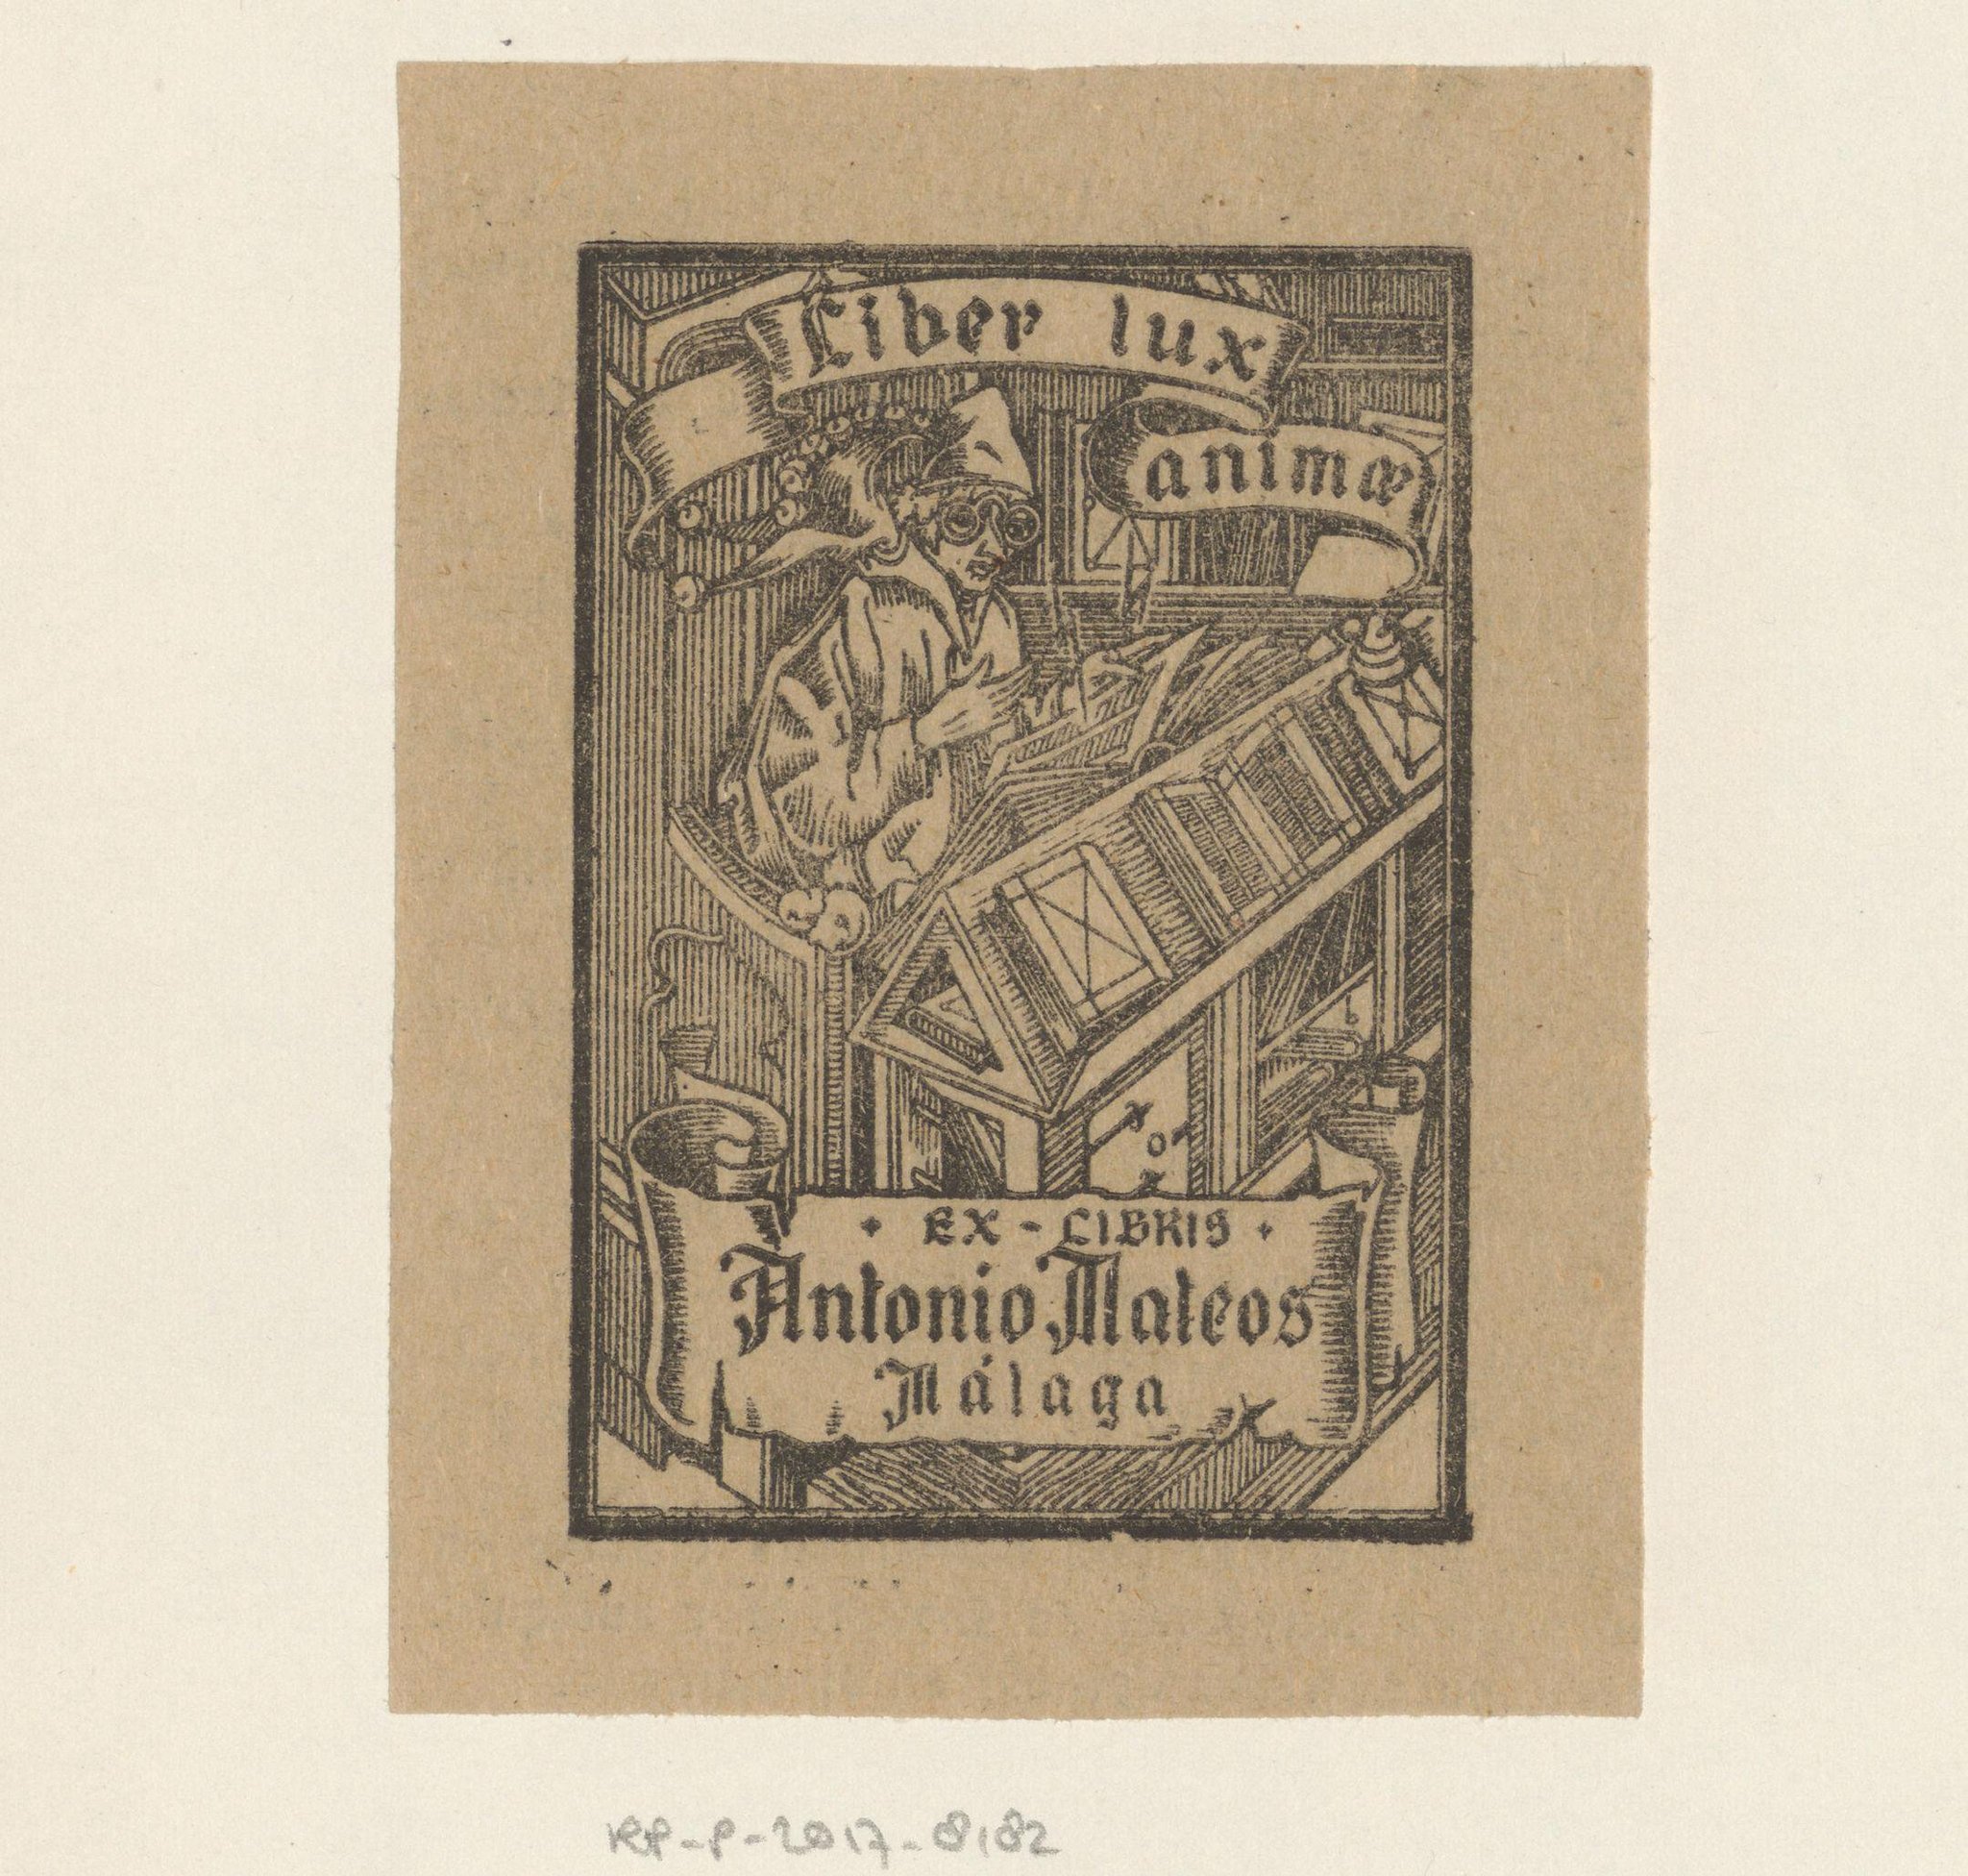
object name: bookplate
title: Ex libris van Antonio Mateos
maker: Anonymous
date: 1900-1999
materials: paper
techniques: printing block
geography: spain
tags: scholar, philosopher, book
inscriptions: inscription, stamp: ‘J. Llop [?]/ [...]/ El Mansoul/ (Barcelona)’